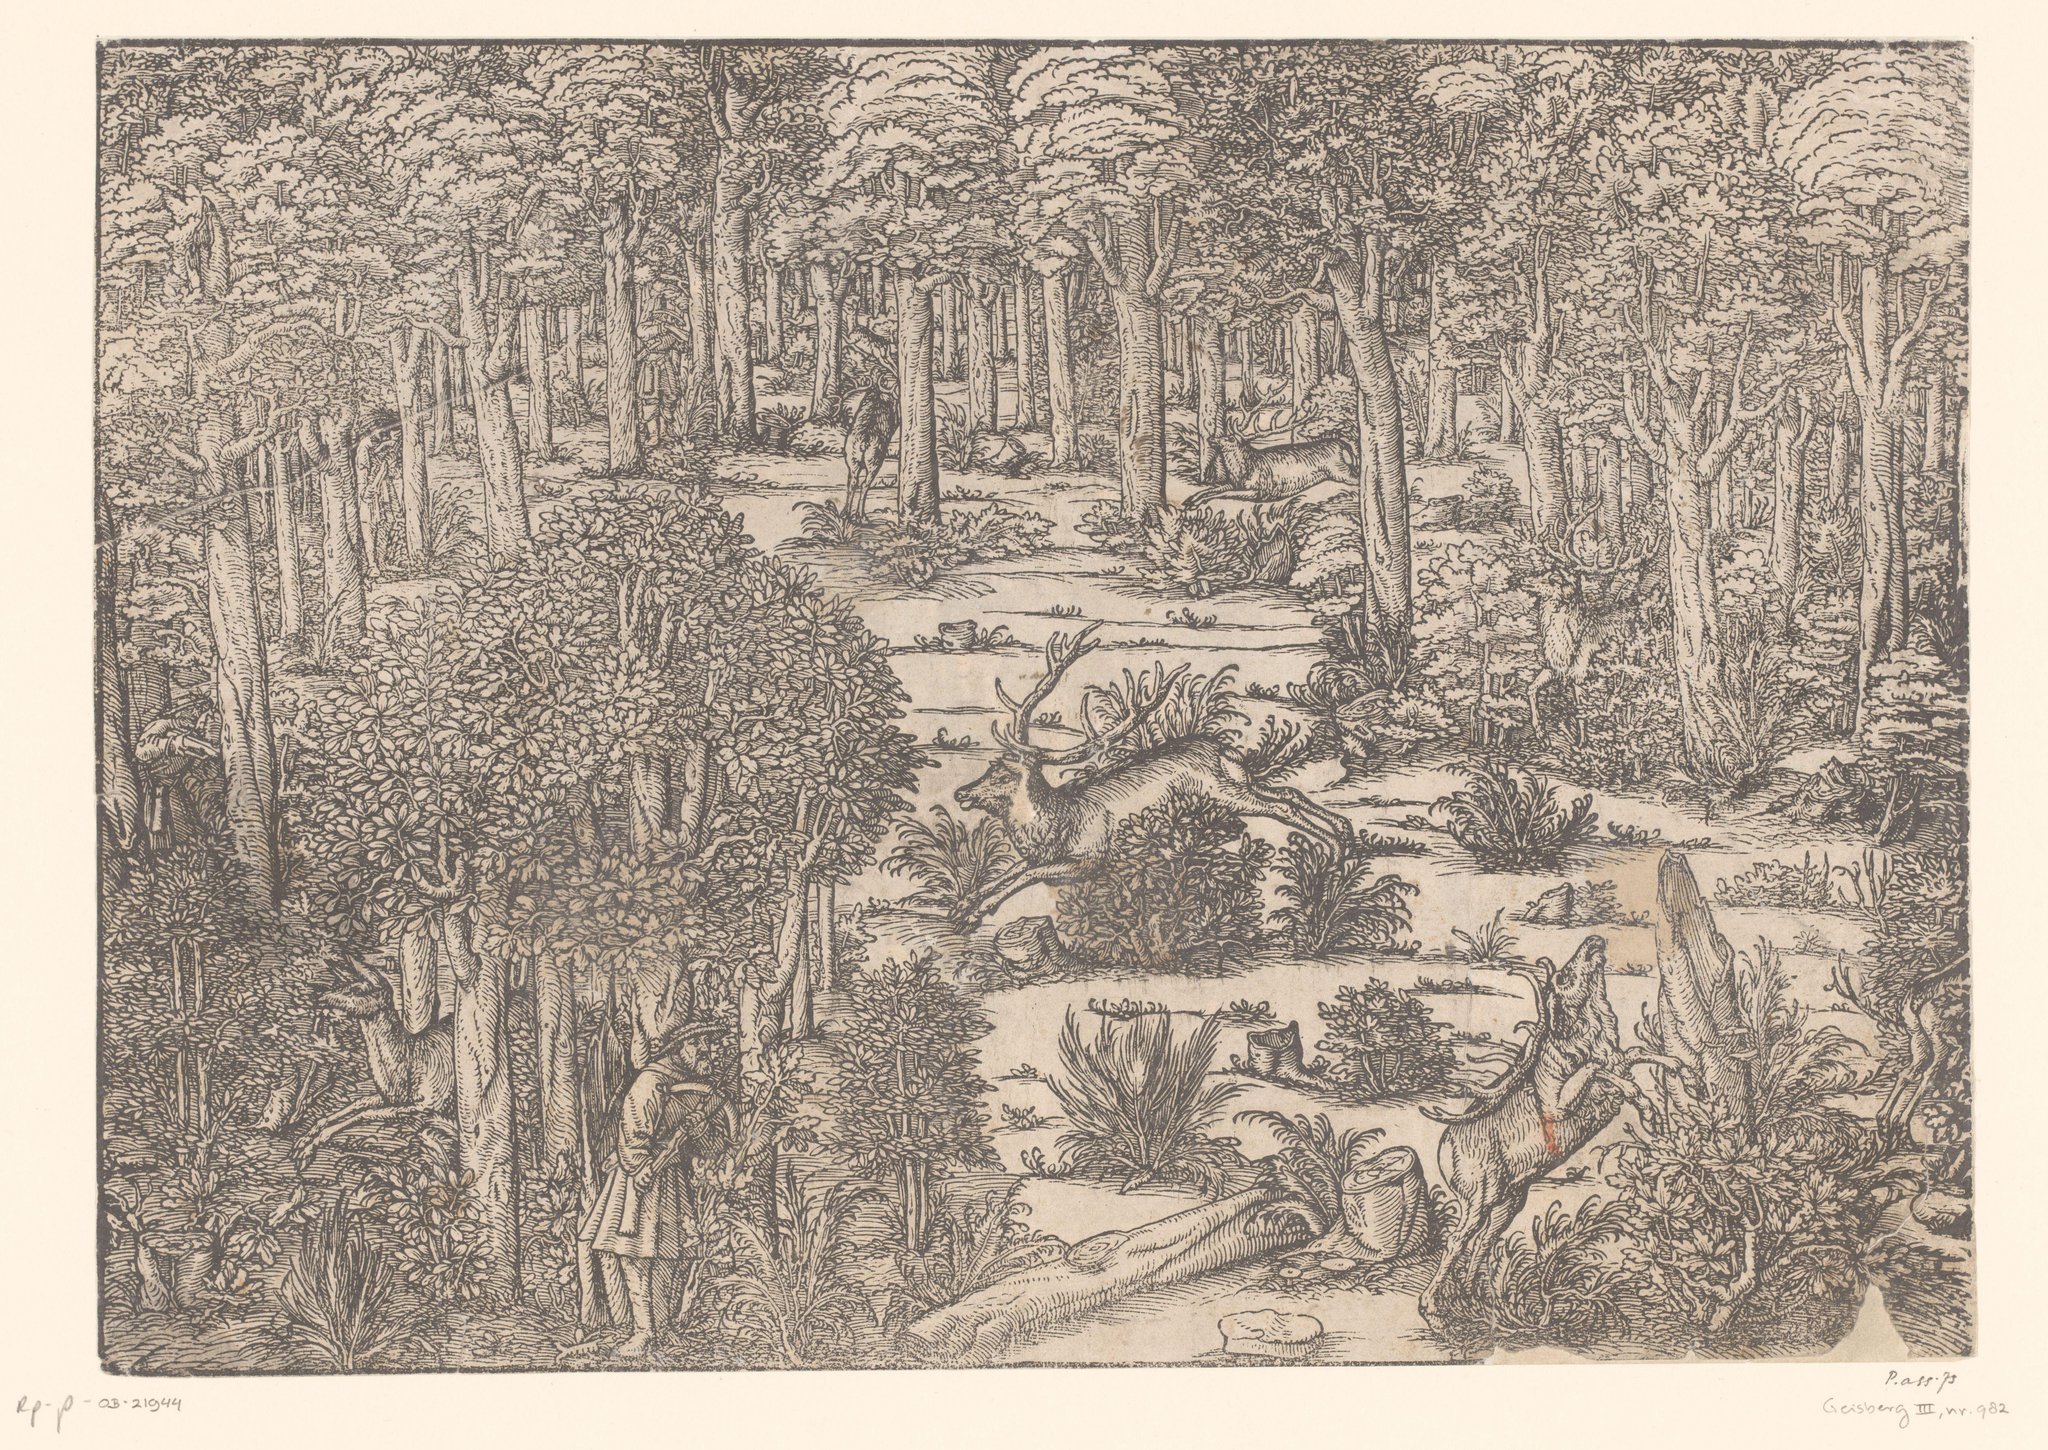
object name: print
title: Hertenjacht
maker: Anonymous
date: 1543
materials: paper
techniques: woodcut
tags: stag-hunting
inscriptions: collector's mark: Lugt 280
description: Kopie van het linkerblok van een serie van drie prenten met een jachtpartij in het woud van Lörs als onderwerp.